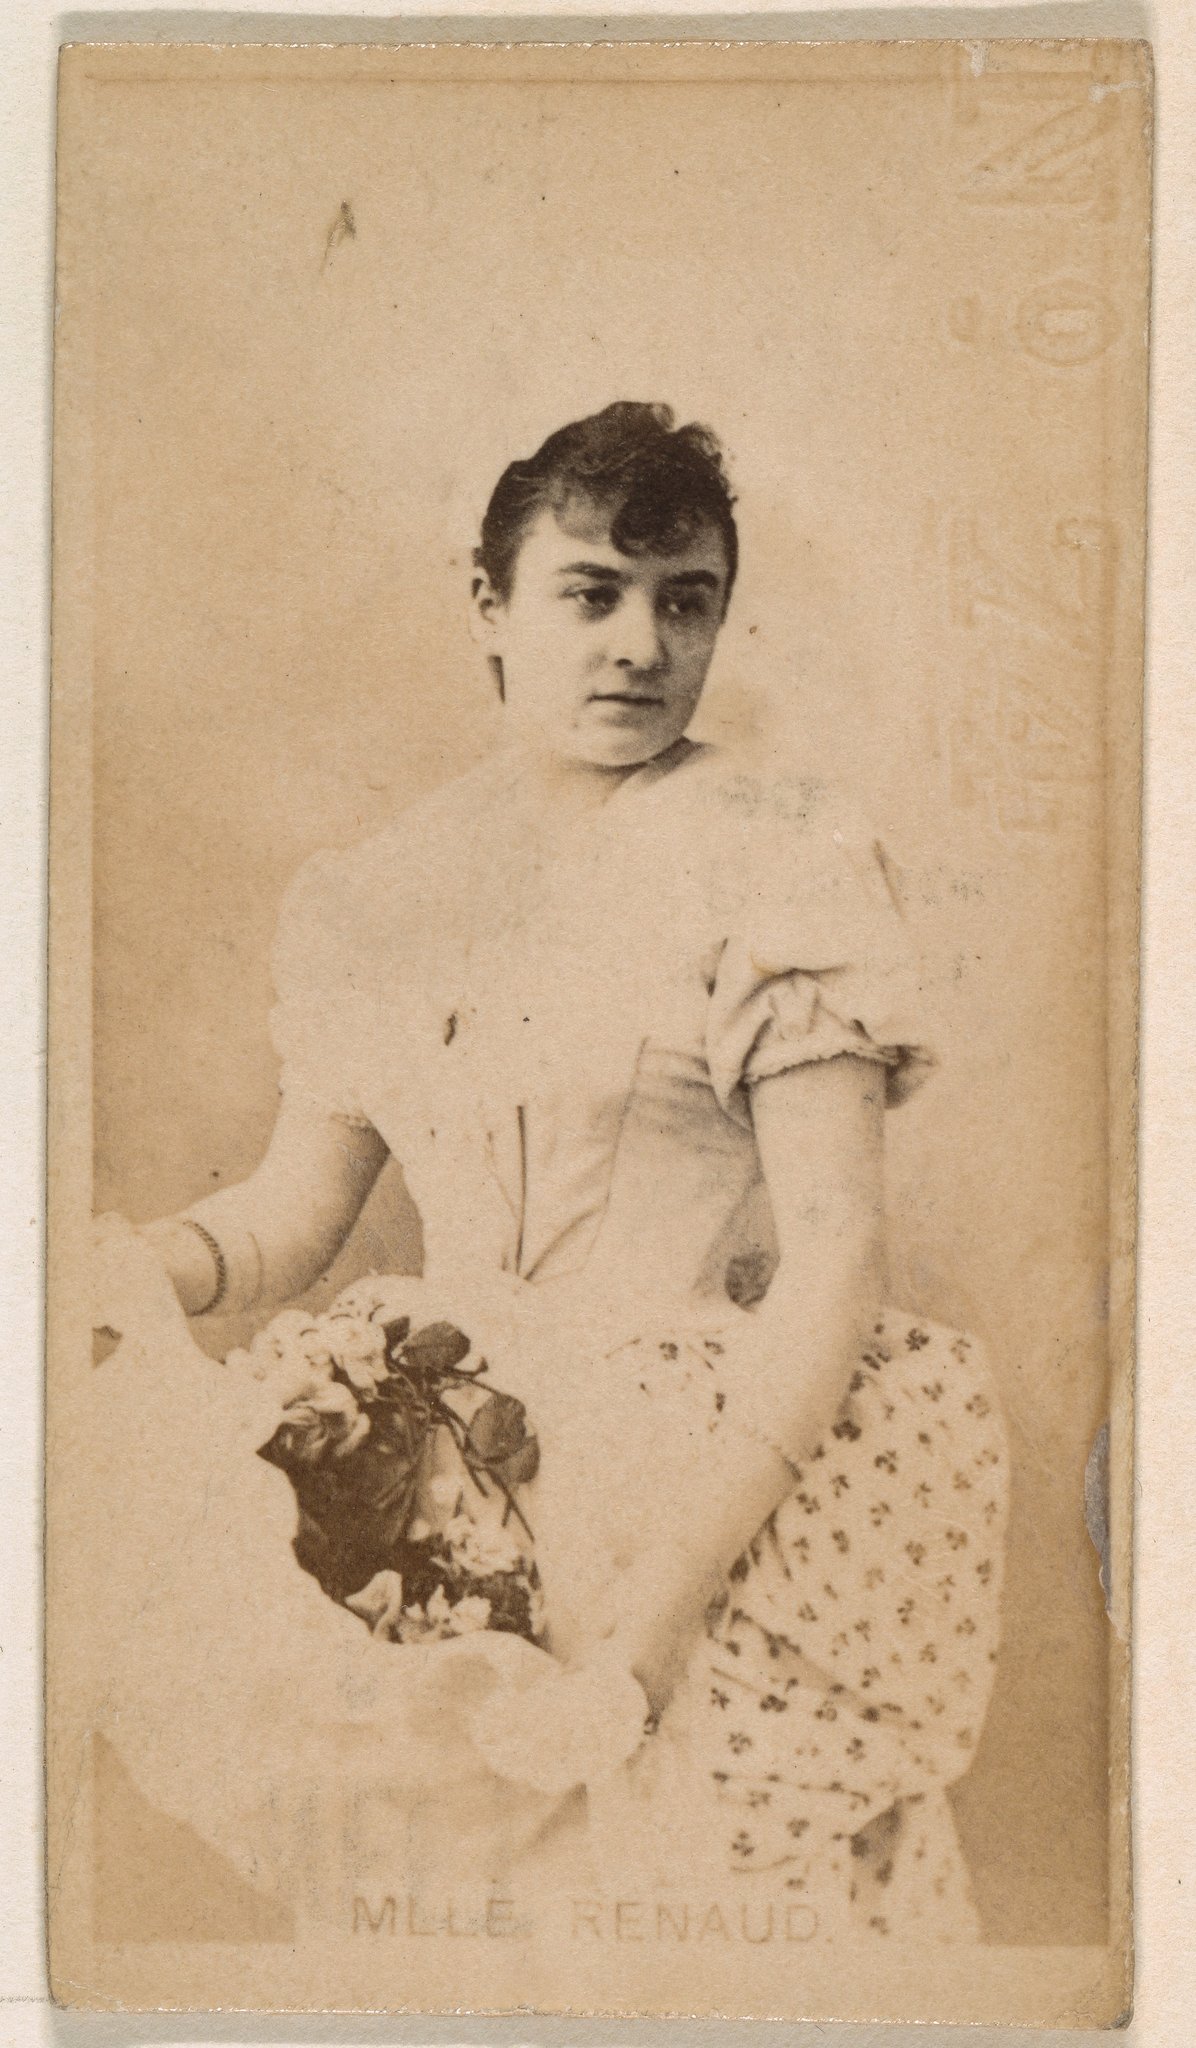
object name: photograph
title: Mlle. Renaud, from the Actresses series (N245) issued by Kinney Brothers to promote Sweet Caporal Cigarettes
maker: kinney brothers tobacco company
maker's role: publisher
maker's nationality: american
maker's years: 1869-2011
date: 1890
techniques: albumen silver print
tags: portraits,women,actresses